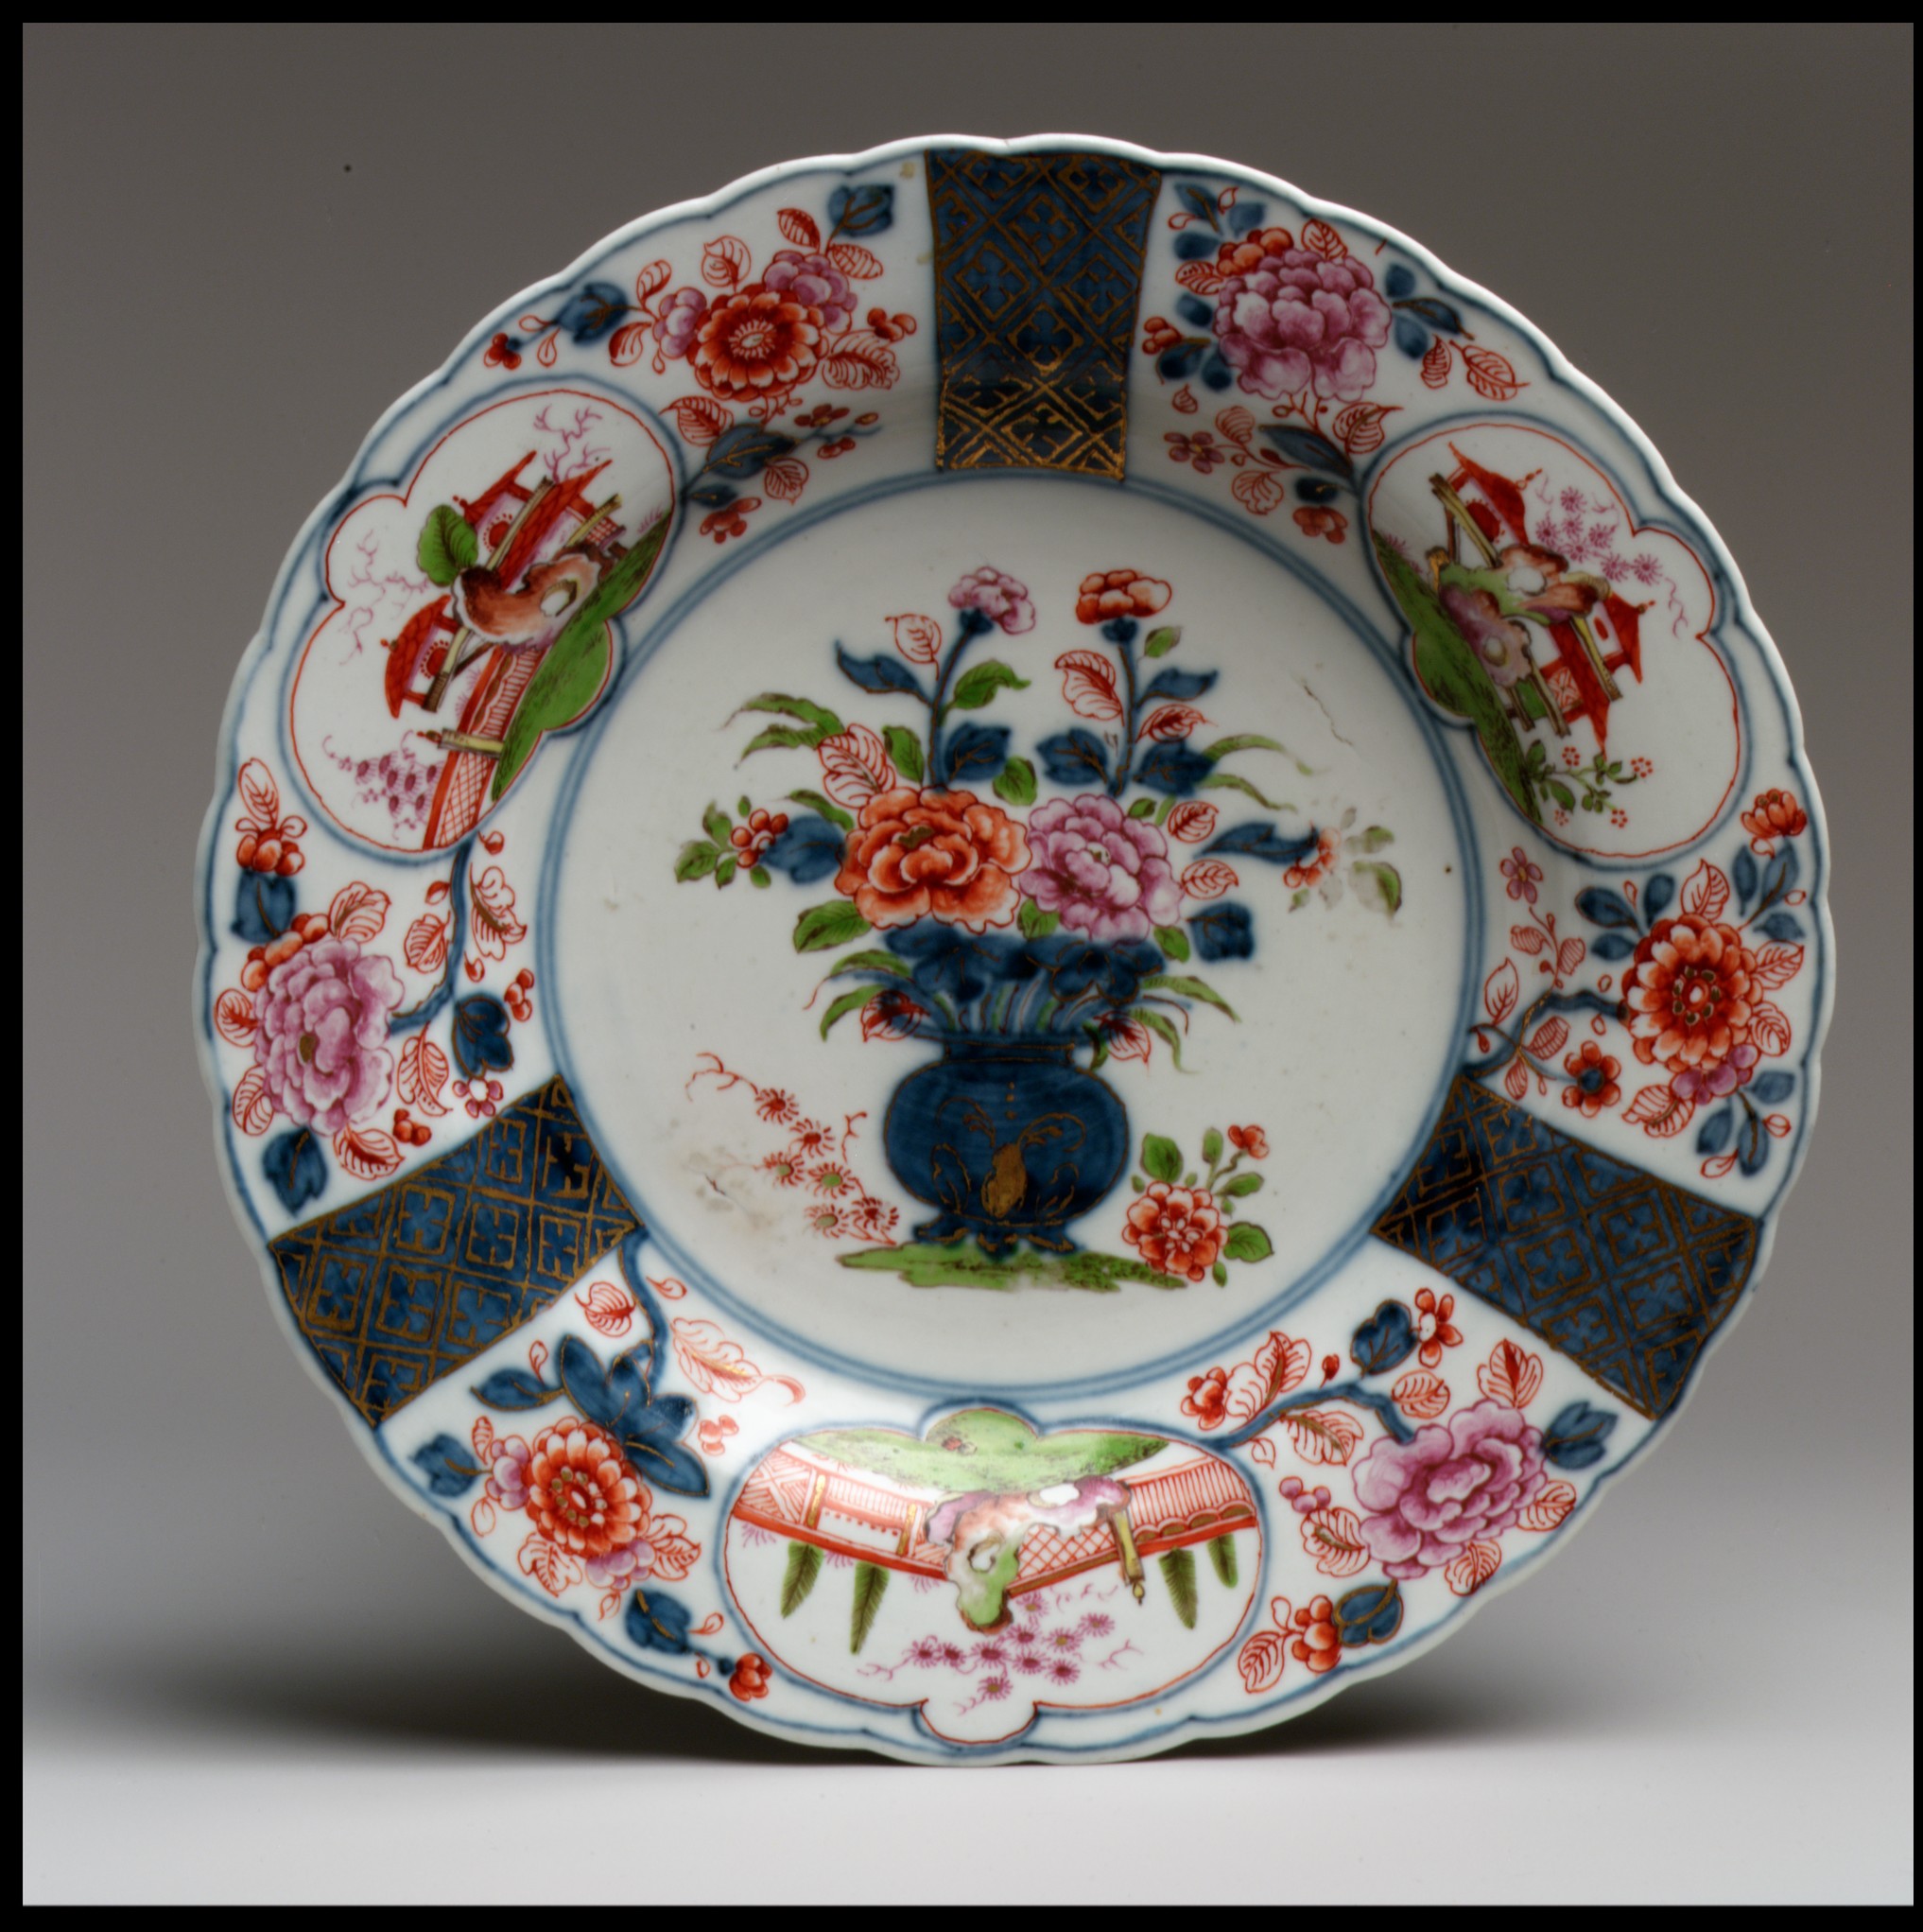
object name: plate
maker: imperial porcelain manufactory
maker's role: manufactory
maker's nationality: austrian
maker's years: 1744-1864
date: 1755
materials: hard paste porcelain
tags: flowers